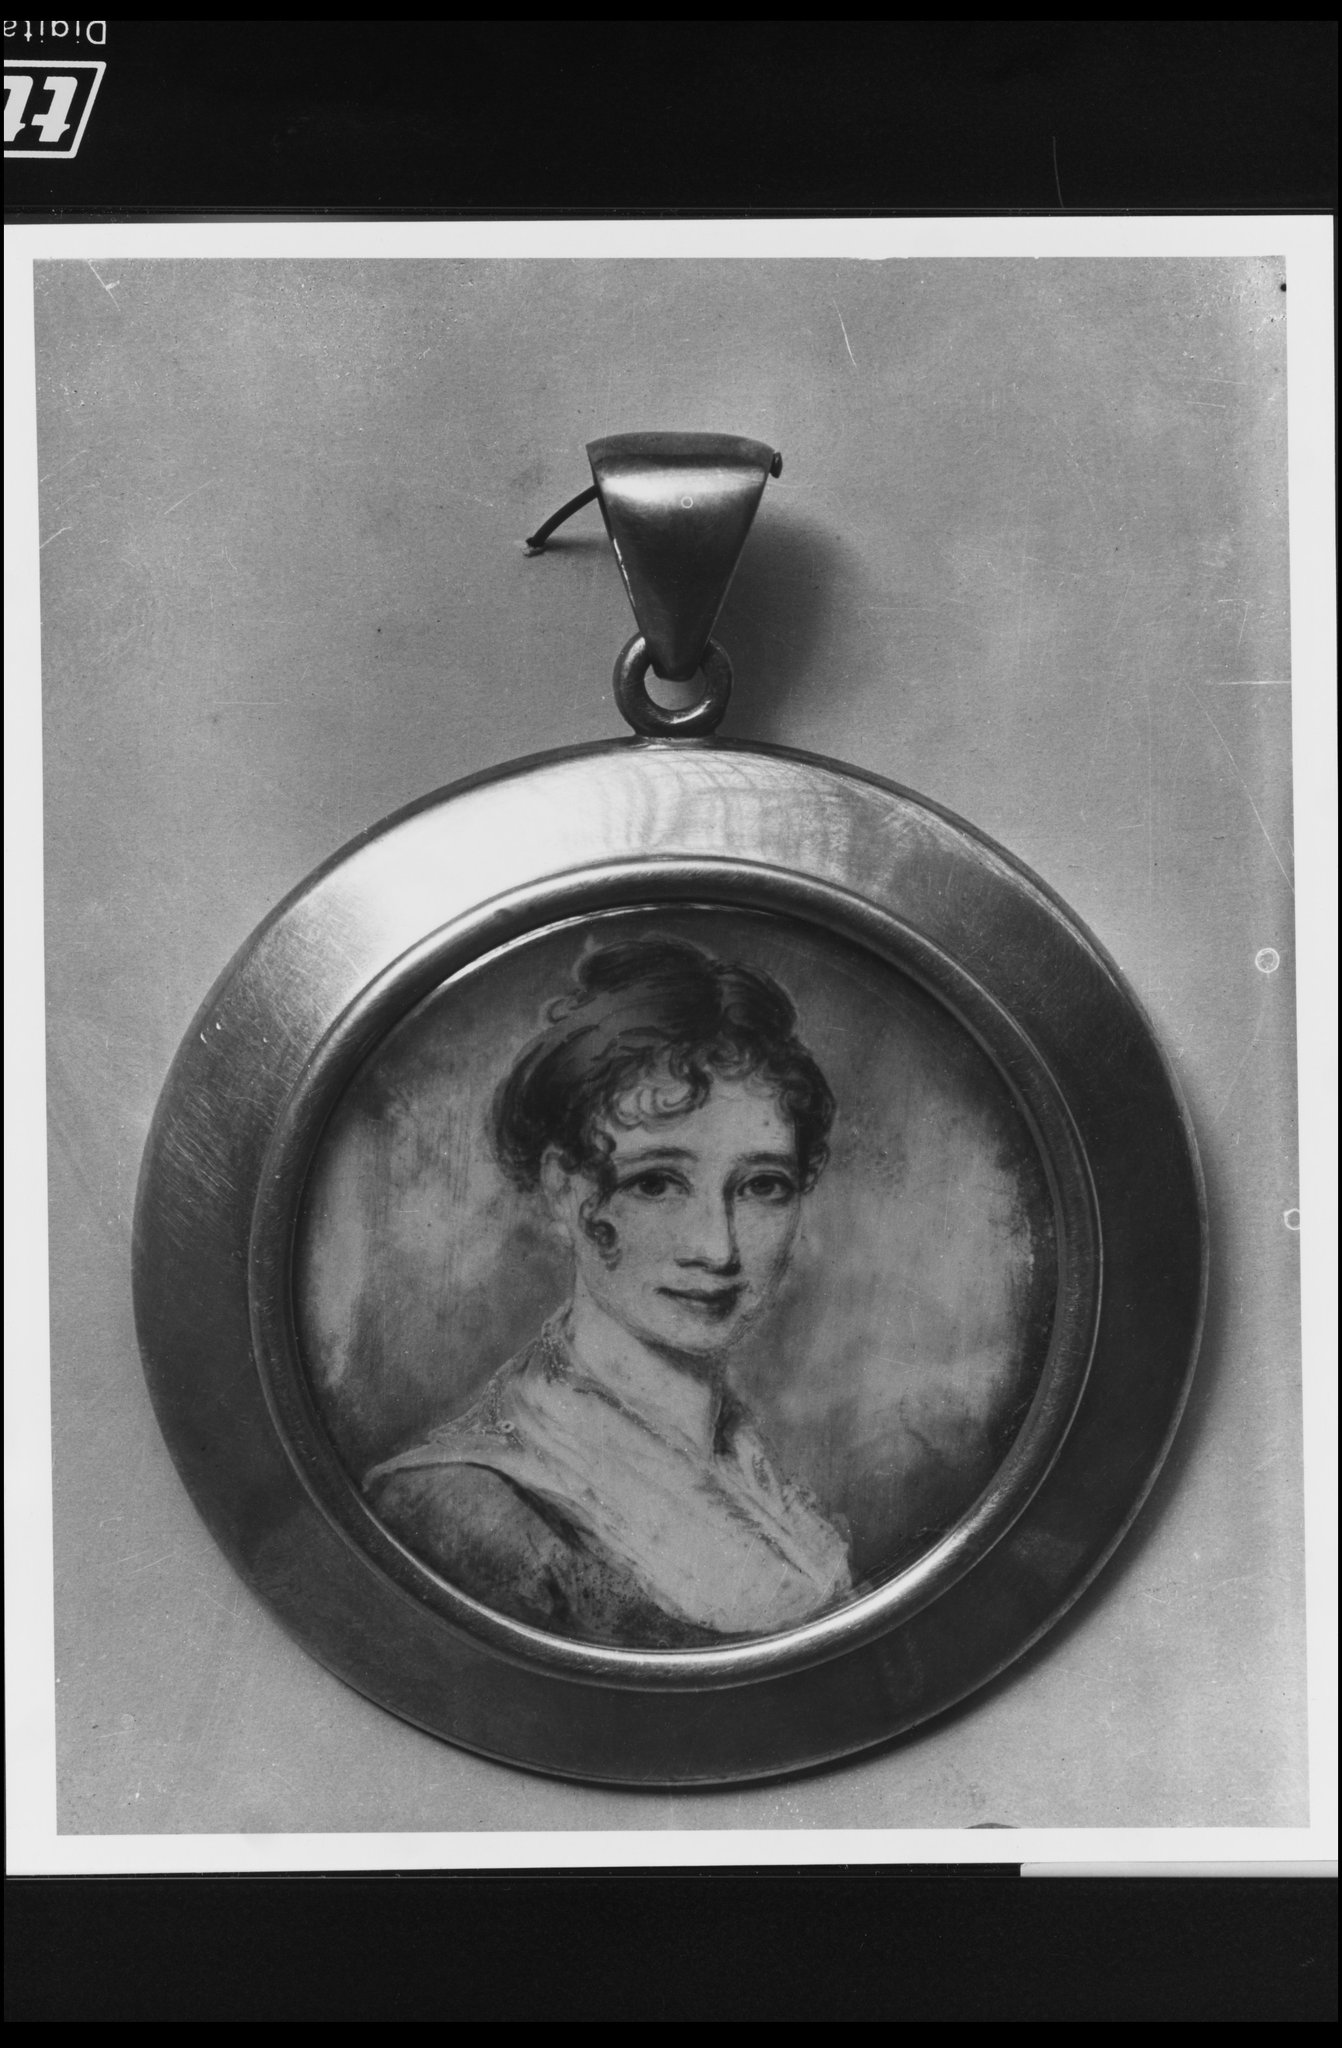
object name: painting, miniature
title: Mrs. Thomas Sully (Sarah Annis)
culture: american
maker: thomas sully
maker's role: artist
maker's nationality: american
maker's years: 1783-1872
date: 1802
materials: ivory, watercolor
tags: portraits,women